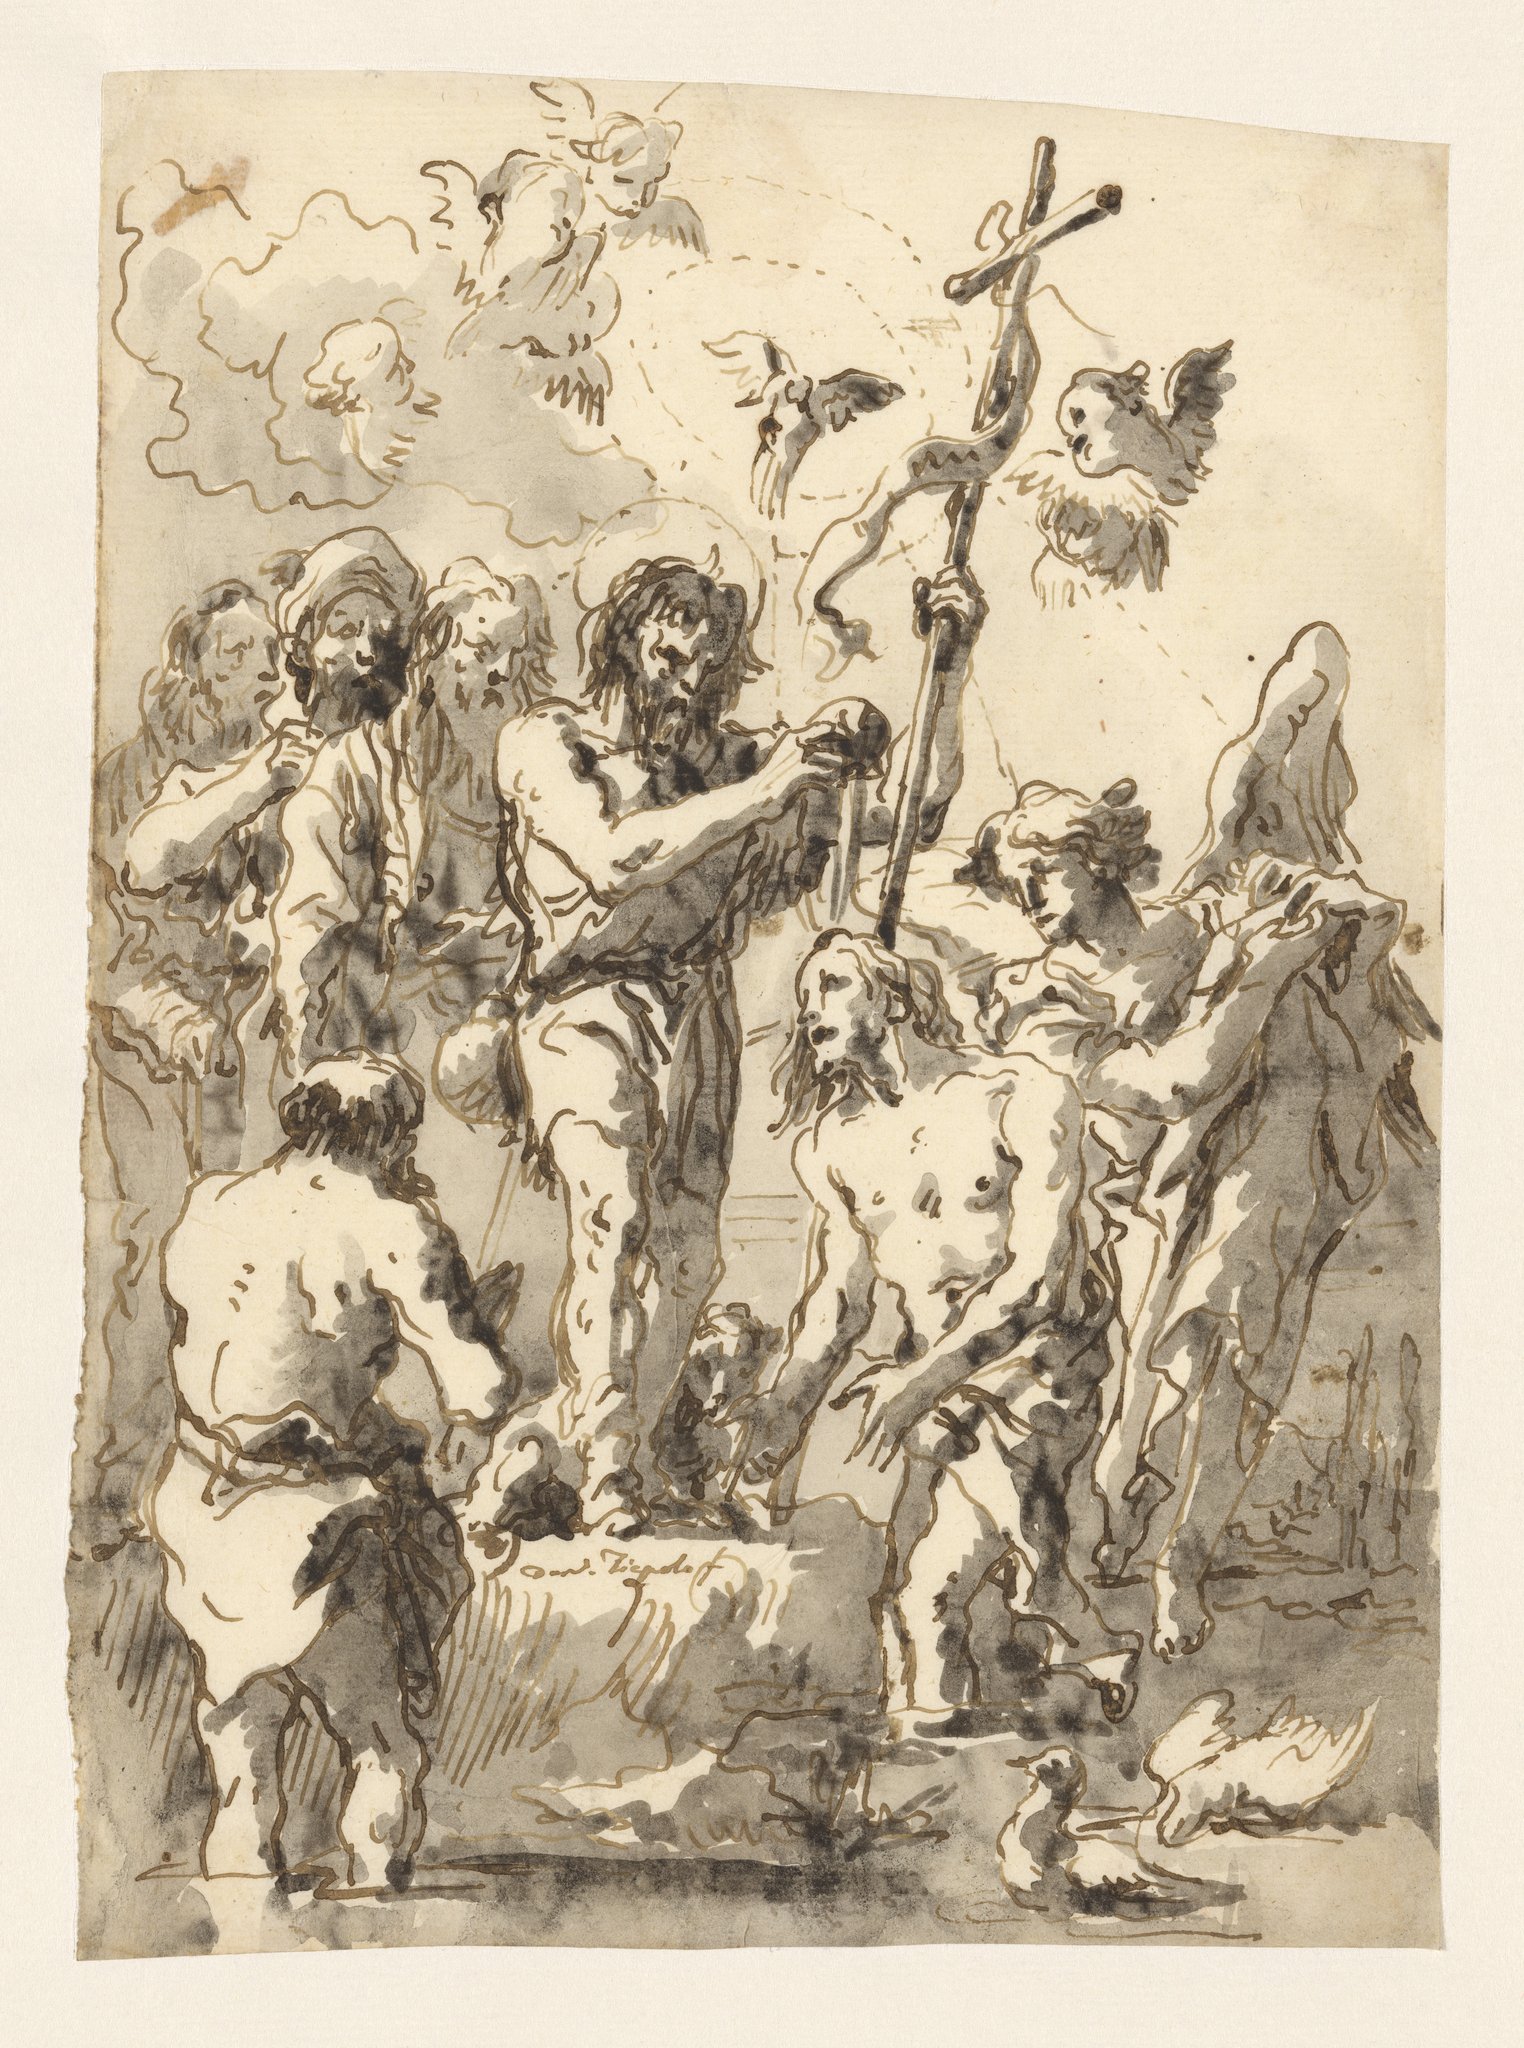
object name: drawing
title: The Baptism of Christ (with Two Ducks in the Water at Lower Right)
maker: giovanni domenico tiepolo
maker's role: artist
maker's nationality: italian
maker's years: 1727-1804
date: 1770-1790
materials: ink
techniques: pen, wash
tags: ducks,men,baptism of christ